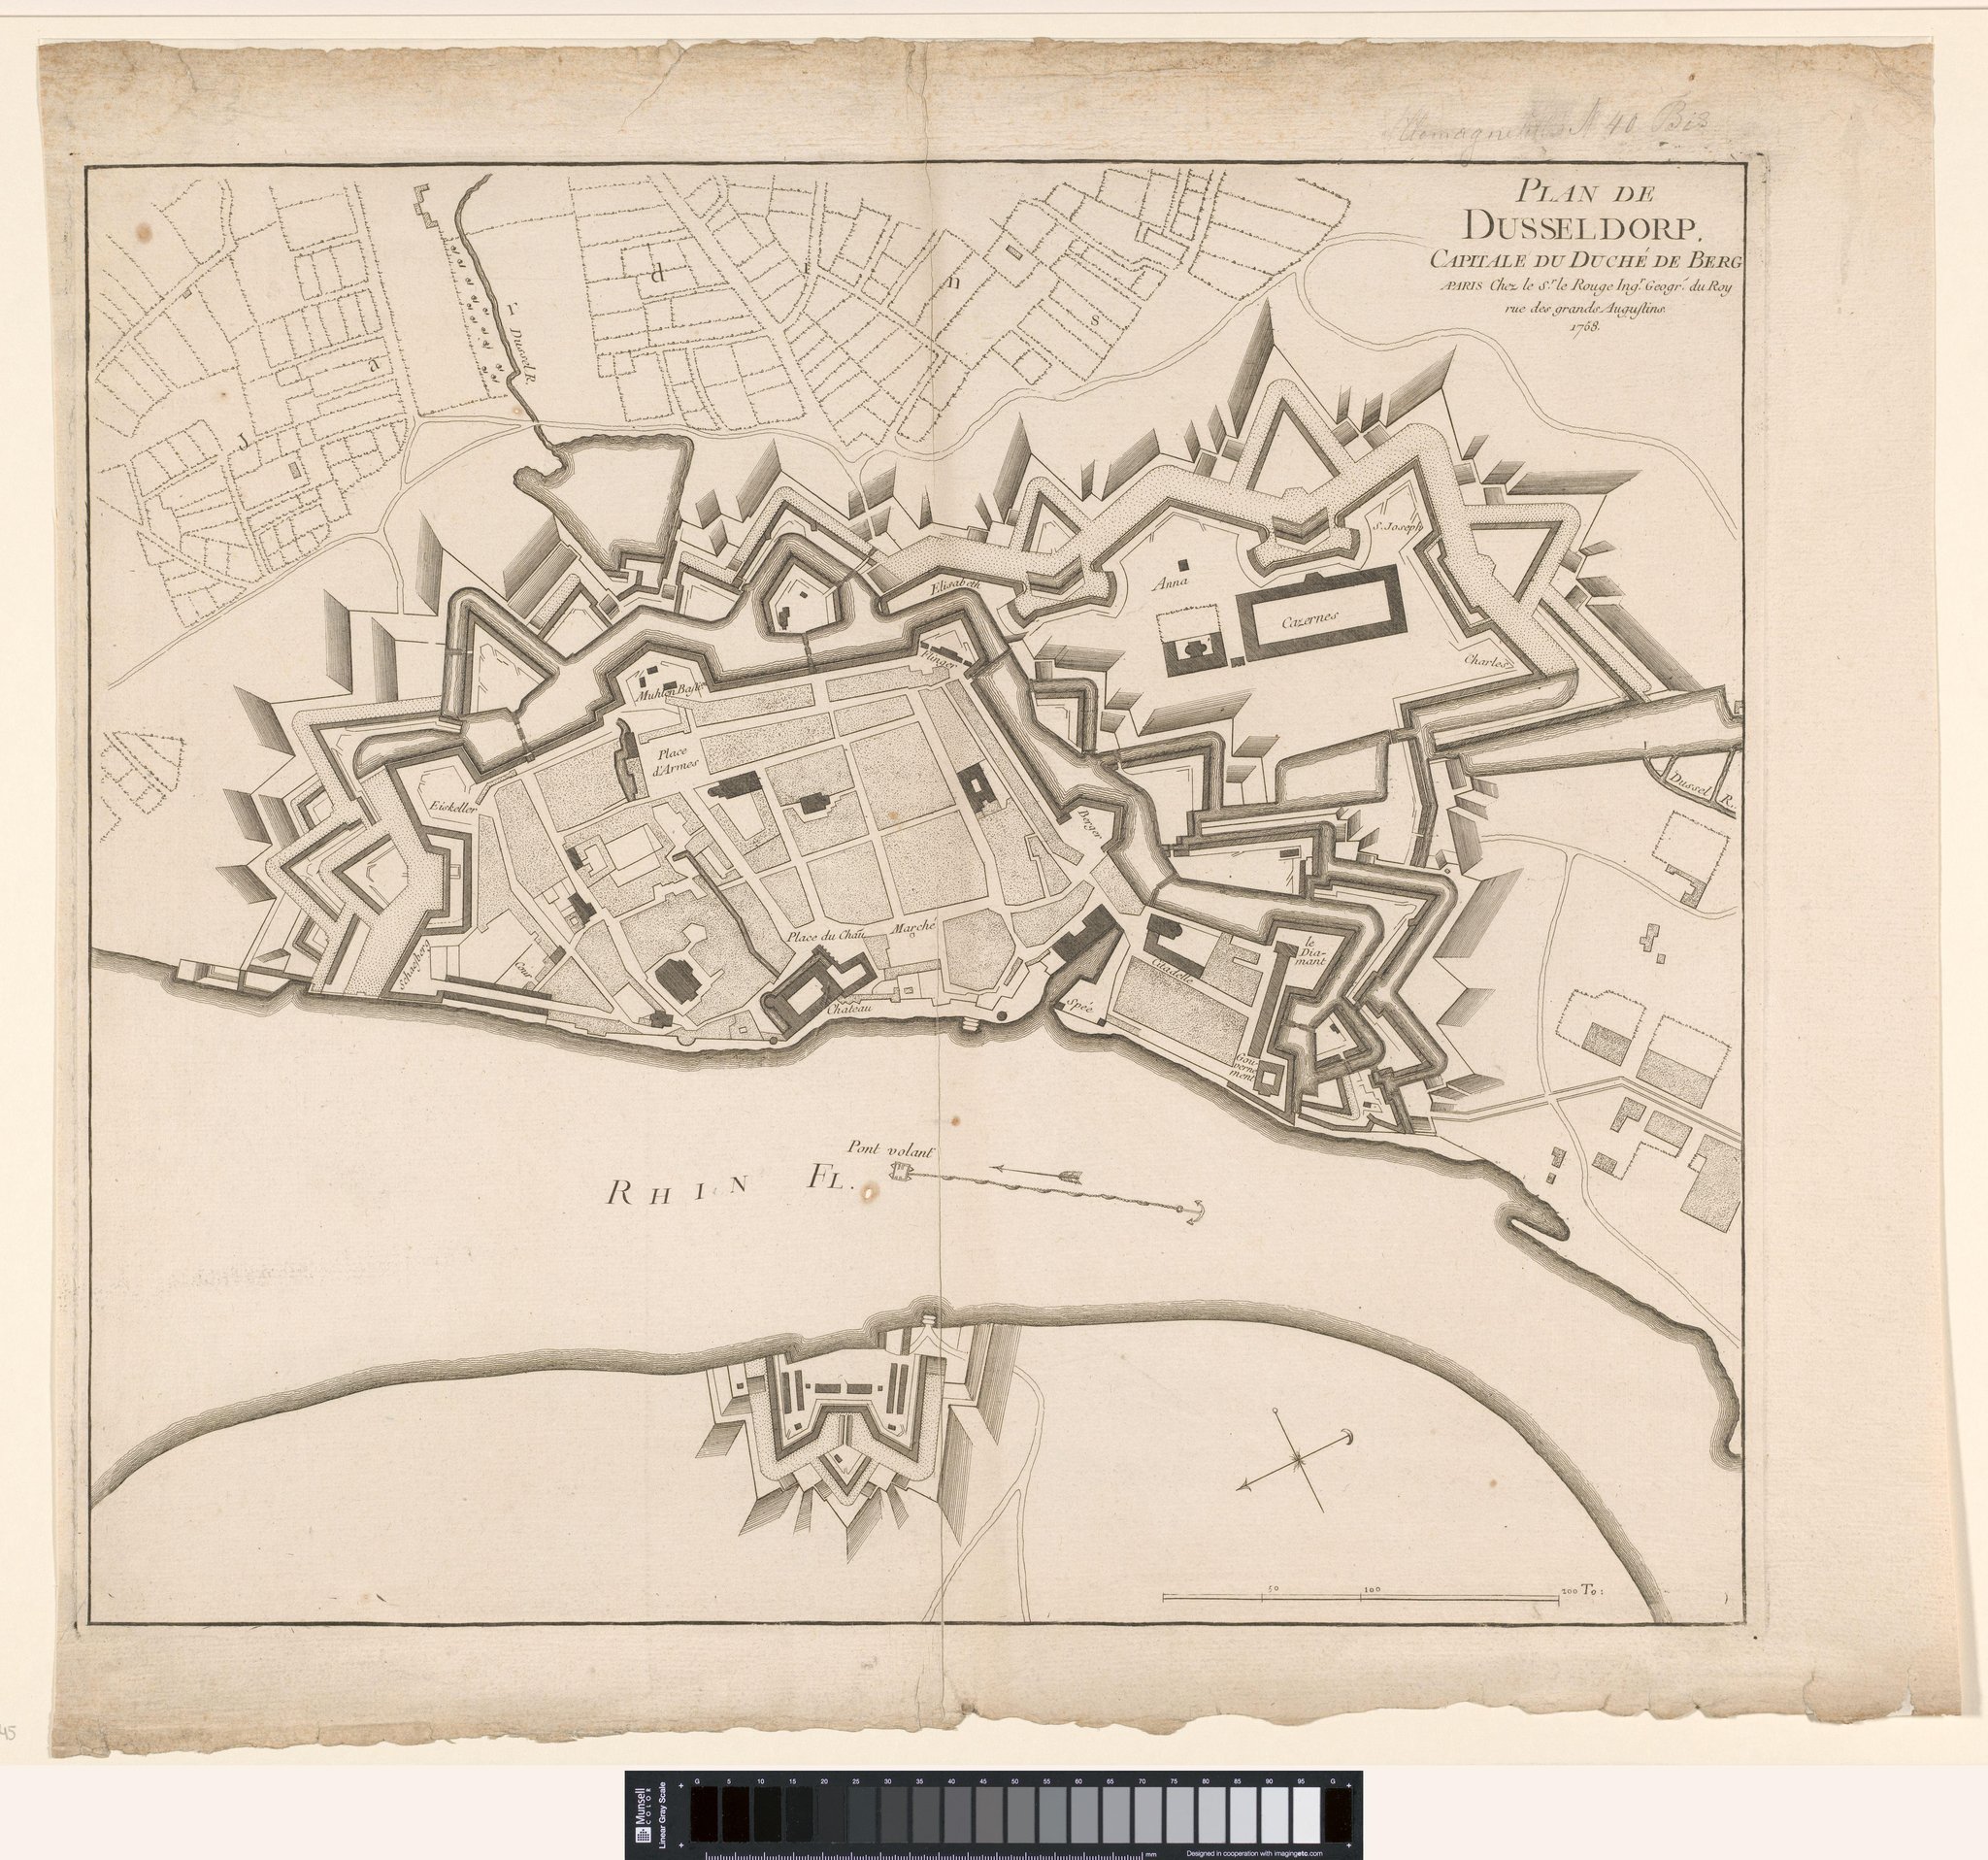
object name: area plan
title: Plattegrond van Düsseldorf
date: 1758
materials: paper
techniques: engraving, etching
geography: paris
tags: maps of cities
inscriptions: collector's mark: Lugt 2228